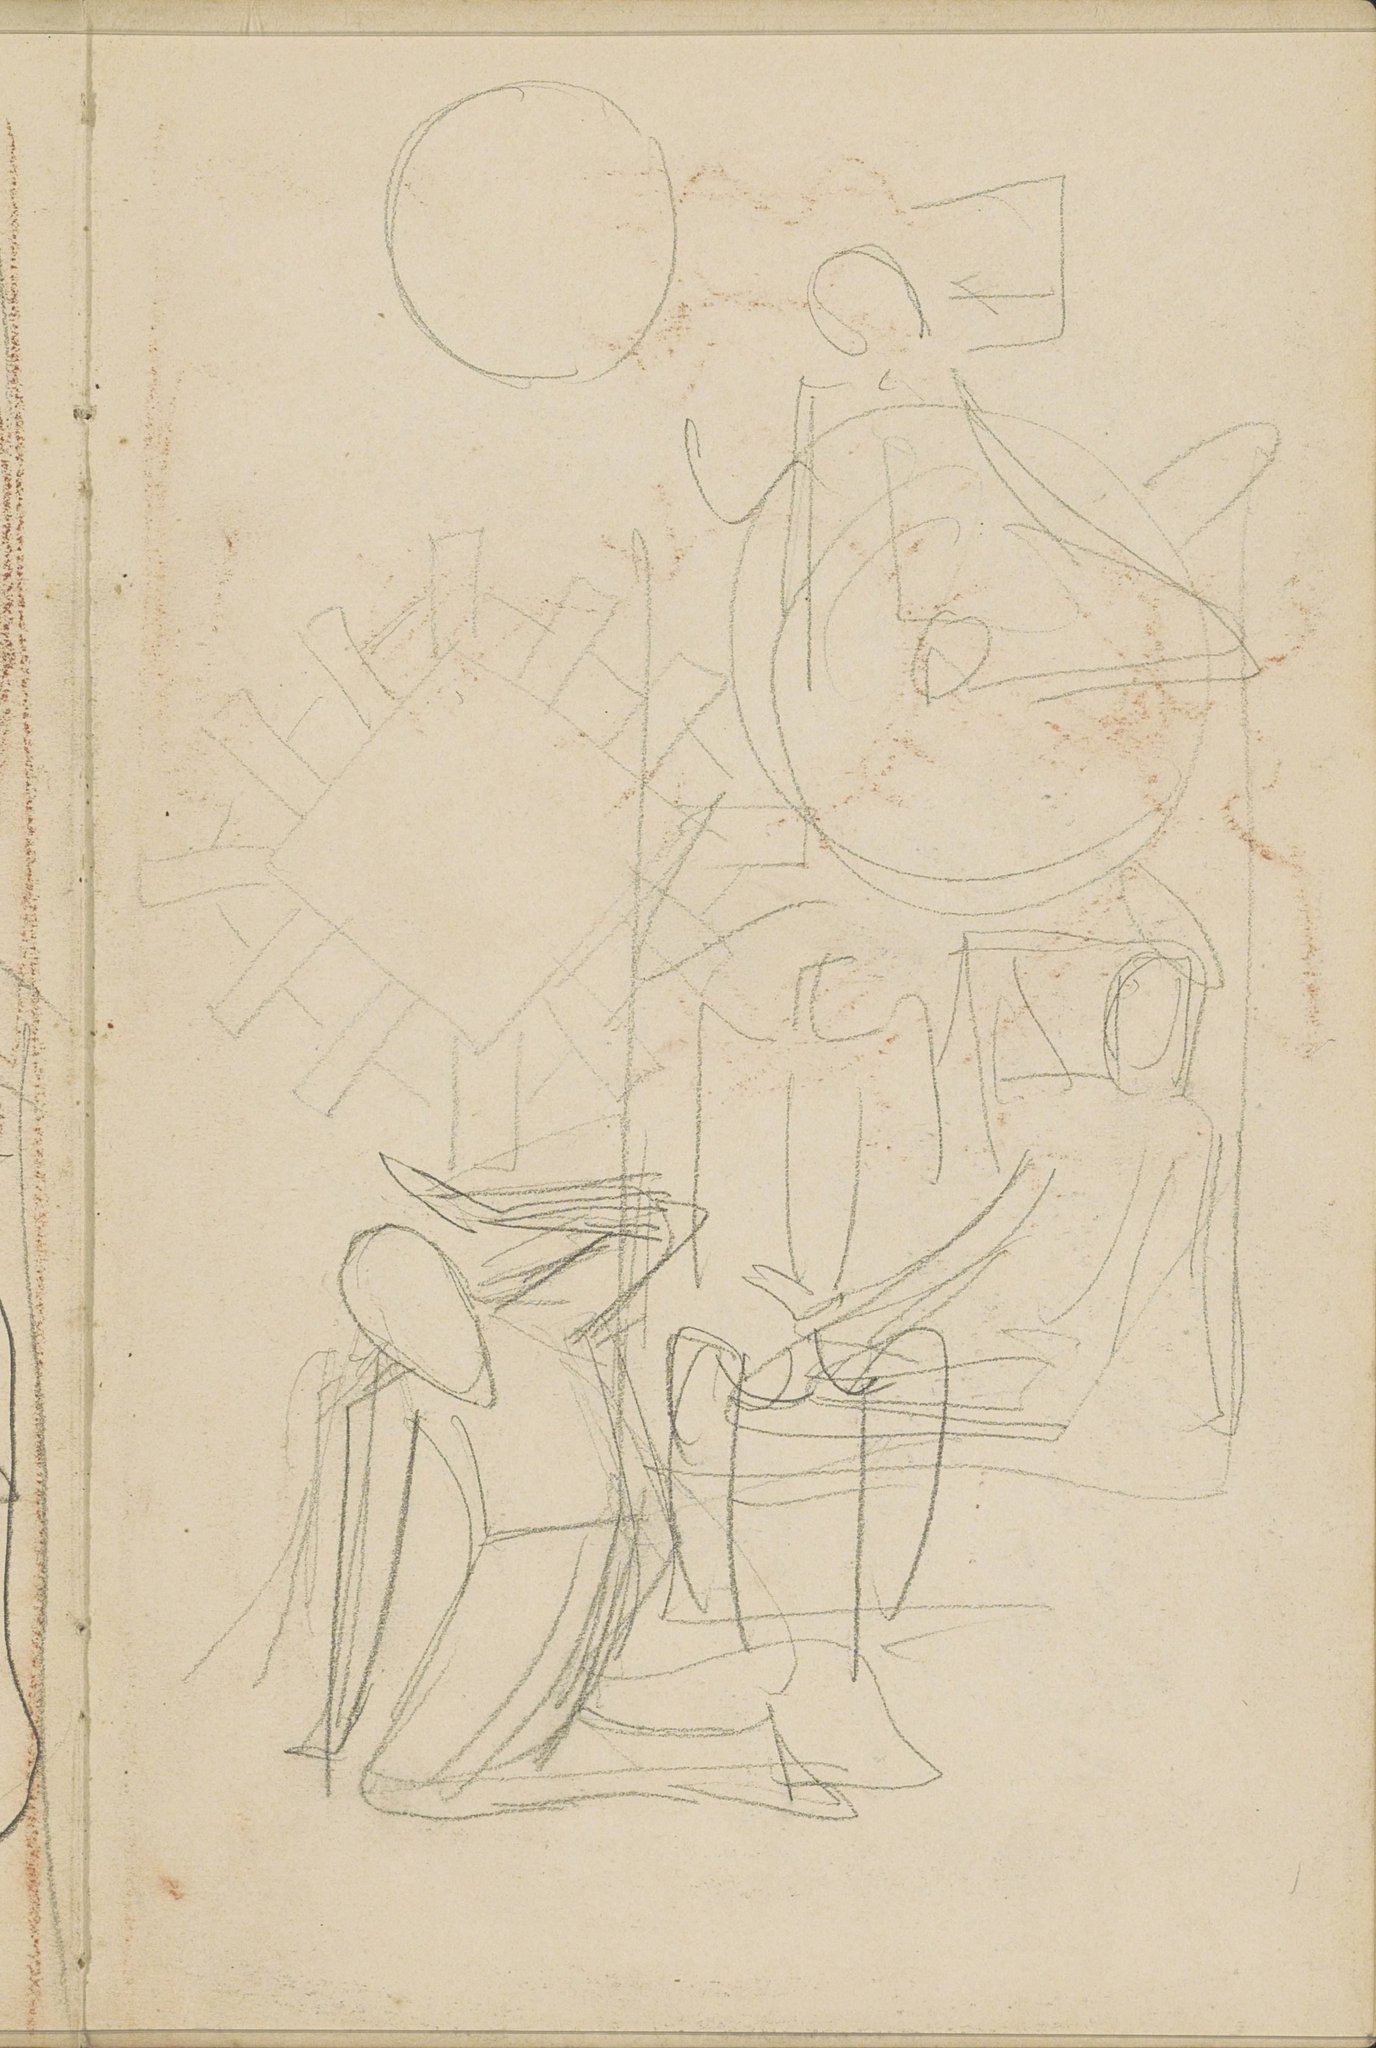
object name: sketchbook leaf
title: Zittende en knielende figuren en cirkels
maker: antoon derkinderen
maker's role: draughtsman, painter, print maker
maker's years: 1859-1925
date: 1889-1891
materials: paper, pencil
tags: sitting figure, kneeling figure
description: Mogelijk voorstudies voor een wandschildering in het stadhuis te Den Bosch. Blad 31 recto uit een schetsboek met 33 bladen.